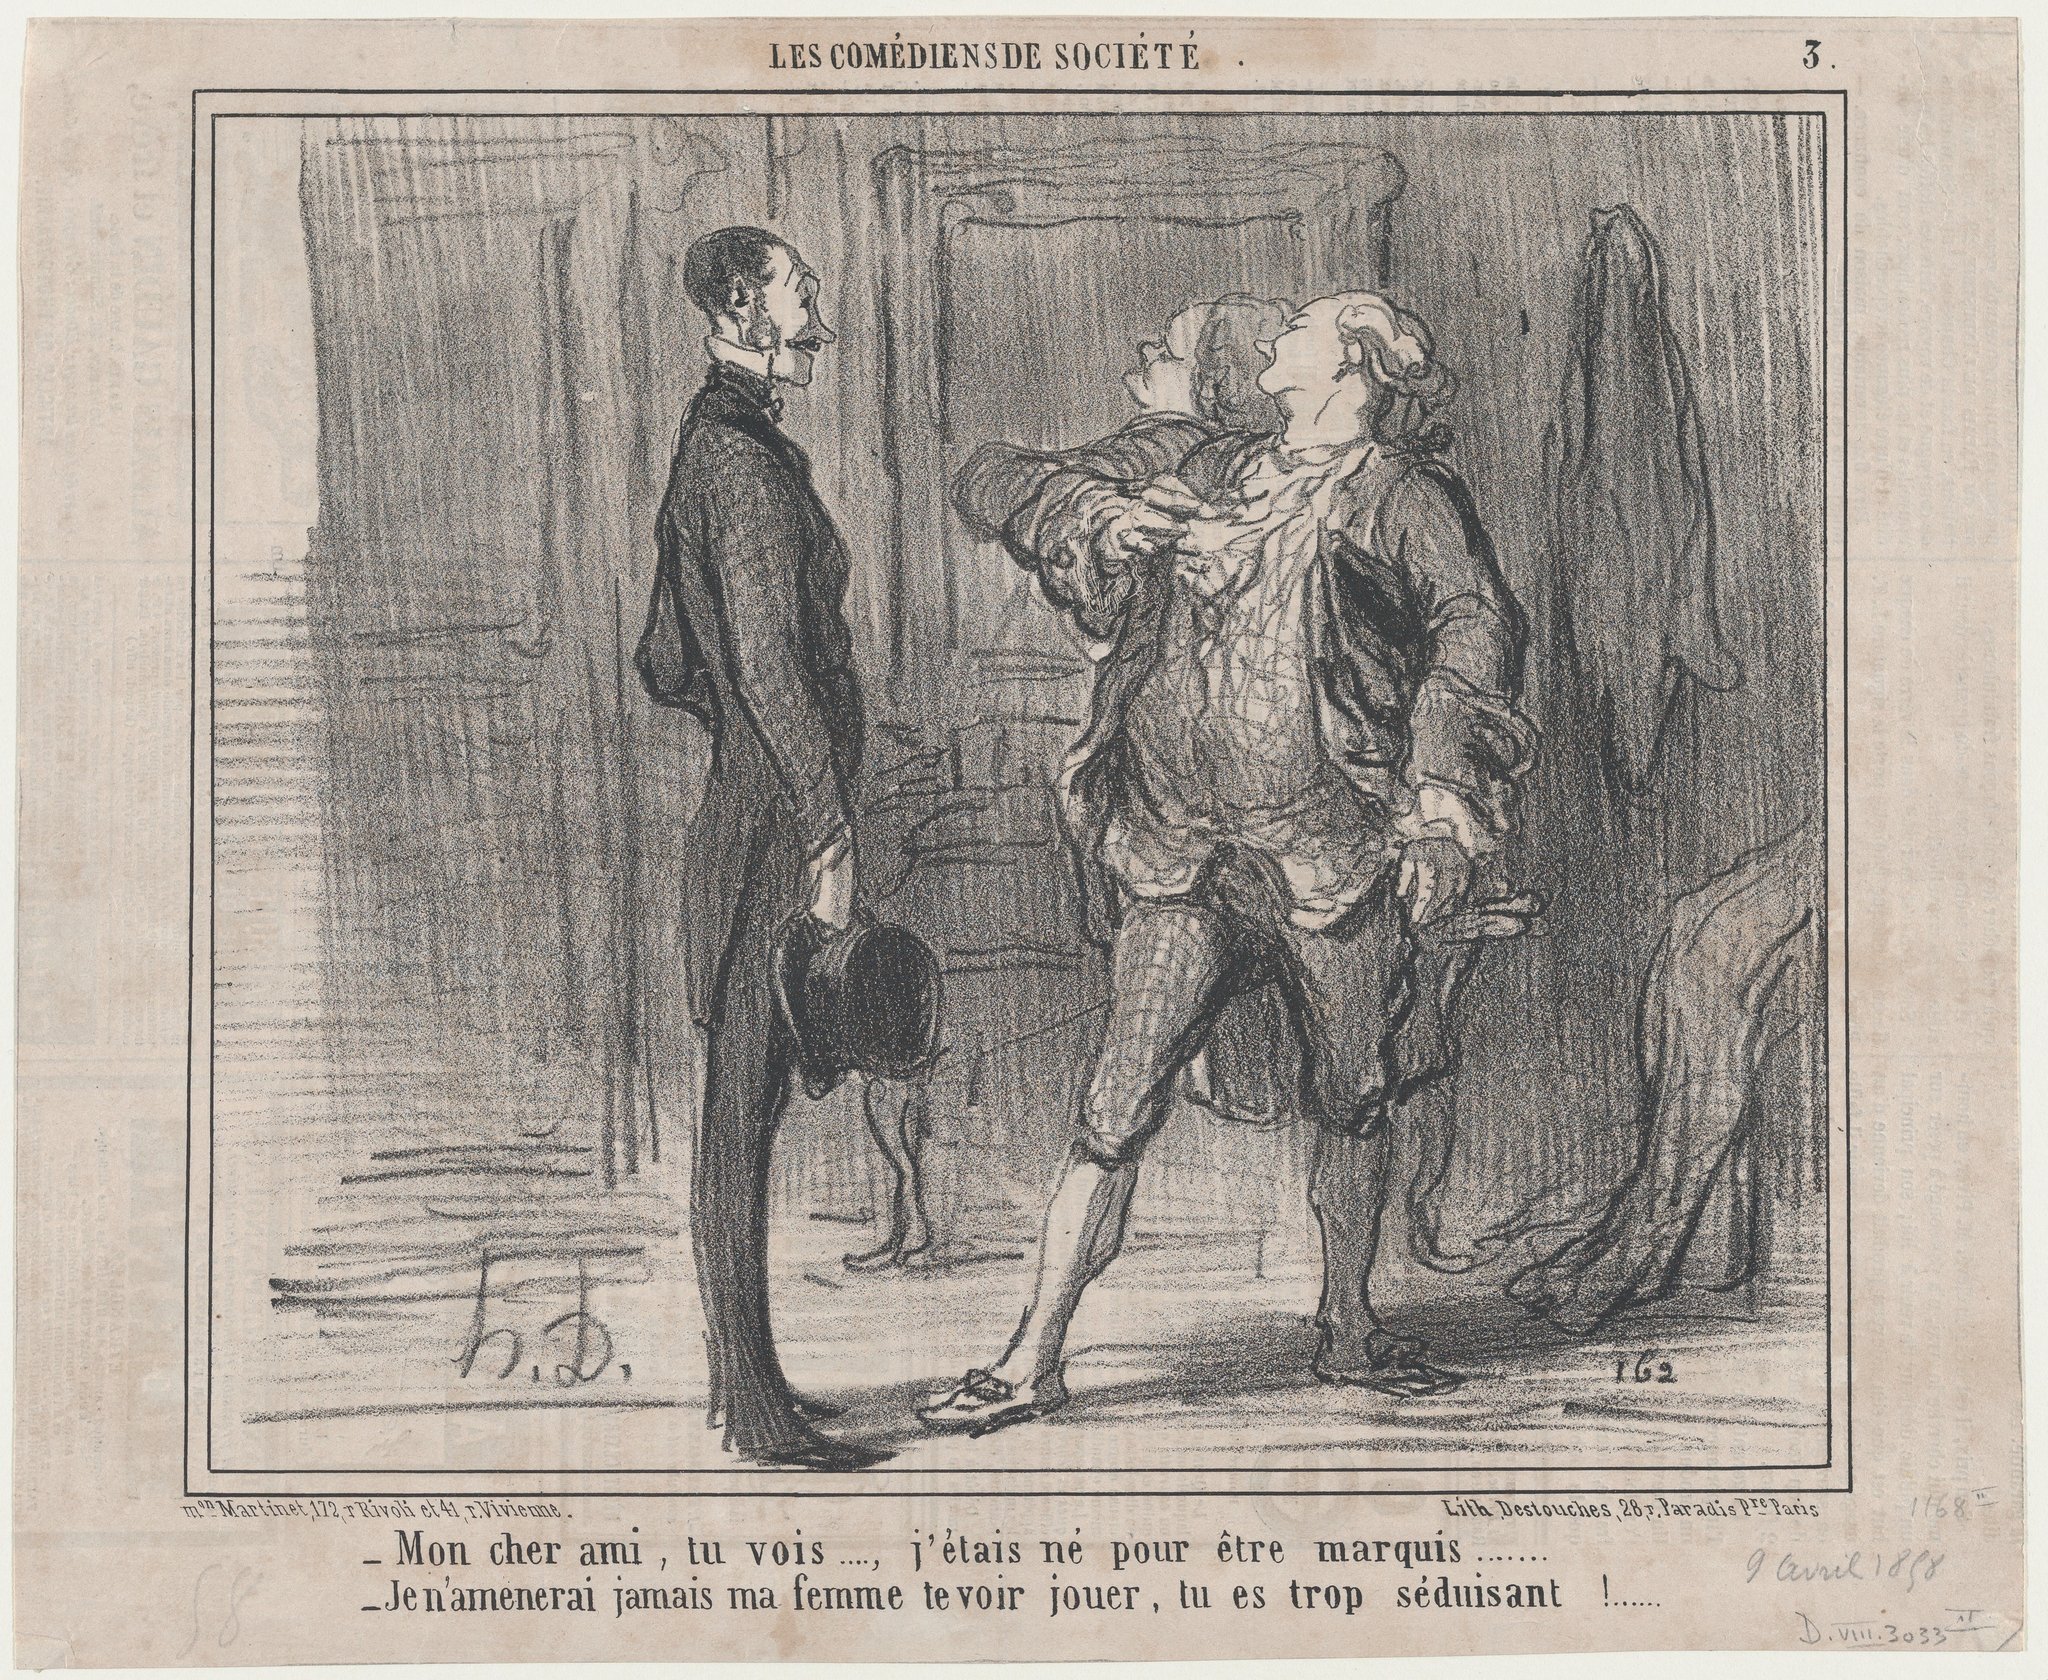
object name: print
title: Mon cheri ami, tu vois..., j'étais né pour être marquis..., from Les Comédiens de Société, published in Le Charivari, April 9, 1858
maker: honoré daumier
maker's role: artist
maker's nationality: french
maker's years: 1808-1879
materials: paper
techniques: lithograph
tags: men